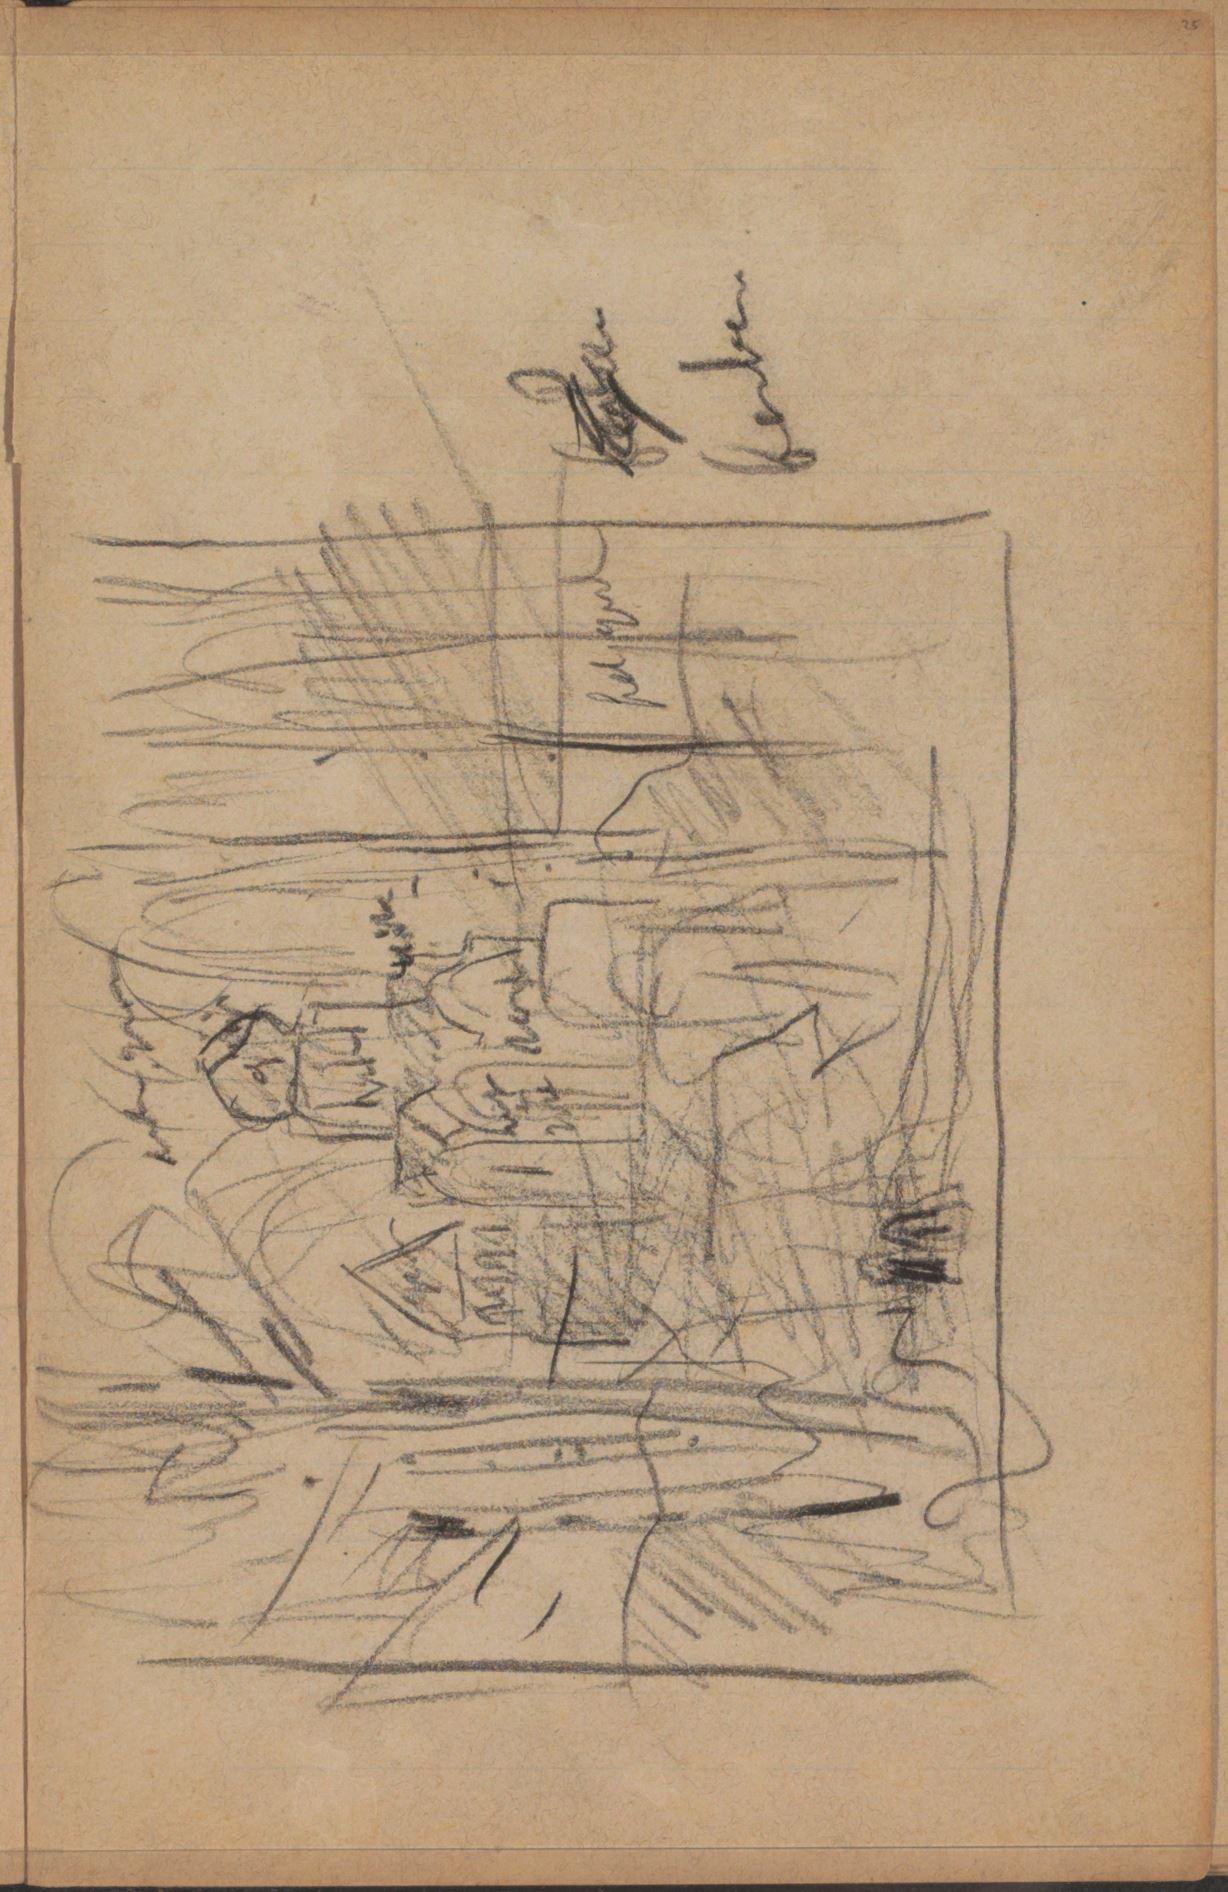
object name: sketchbook leaf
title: Straat met zicht op een toren van het Kremlin, Moskou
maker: marius bauer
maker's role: draughtsman, print maker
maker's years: 1867-1932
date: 1896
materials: chalk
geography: moscow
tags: spire (of tower on house or building), street (+ city(-scape) with figures, staffage)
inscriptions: kleurnotitie, handgeschreven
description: Pagina 25 uit een schetsboek met 50 bladen.